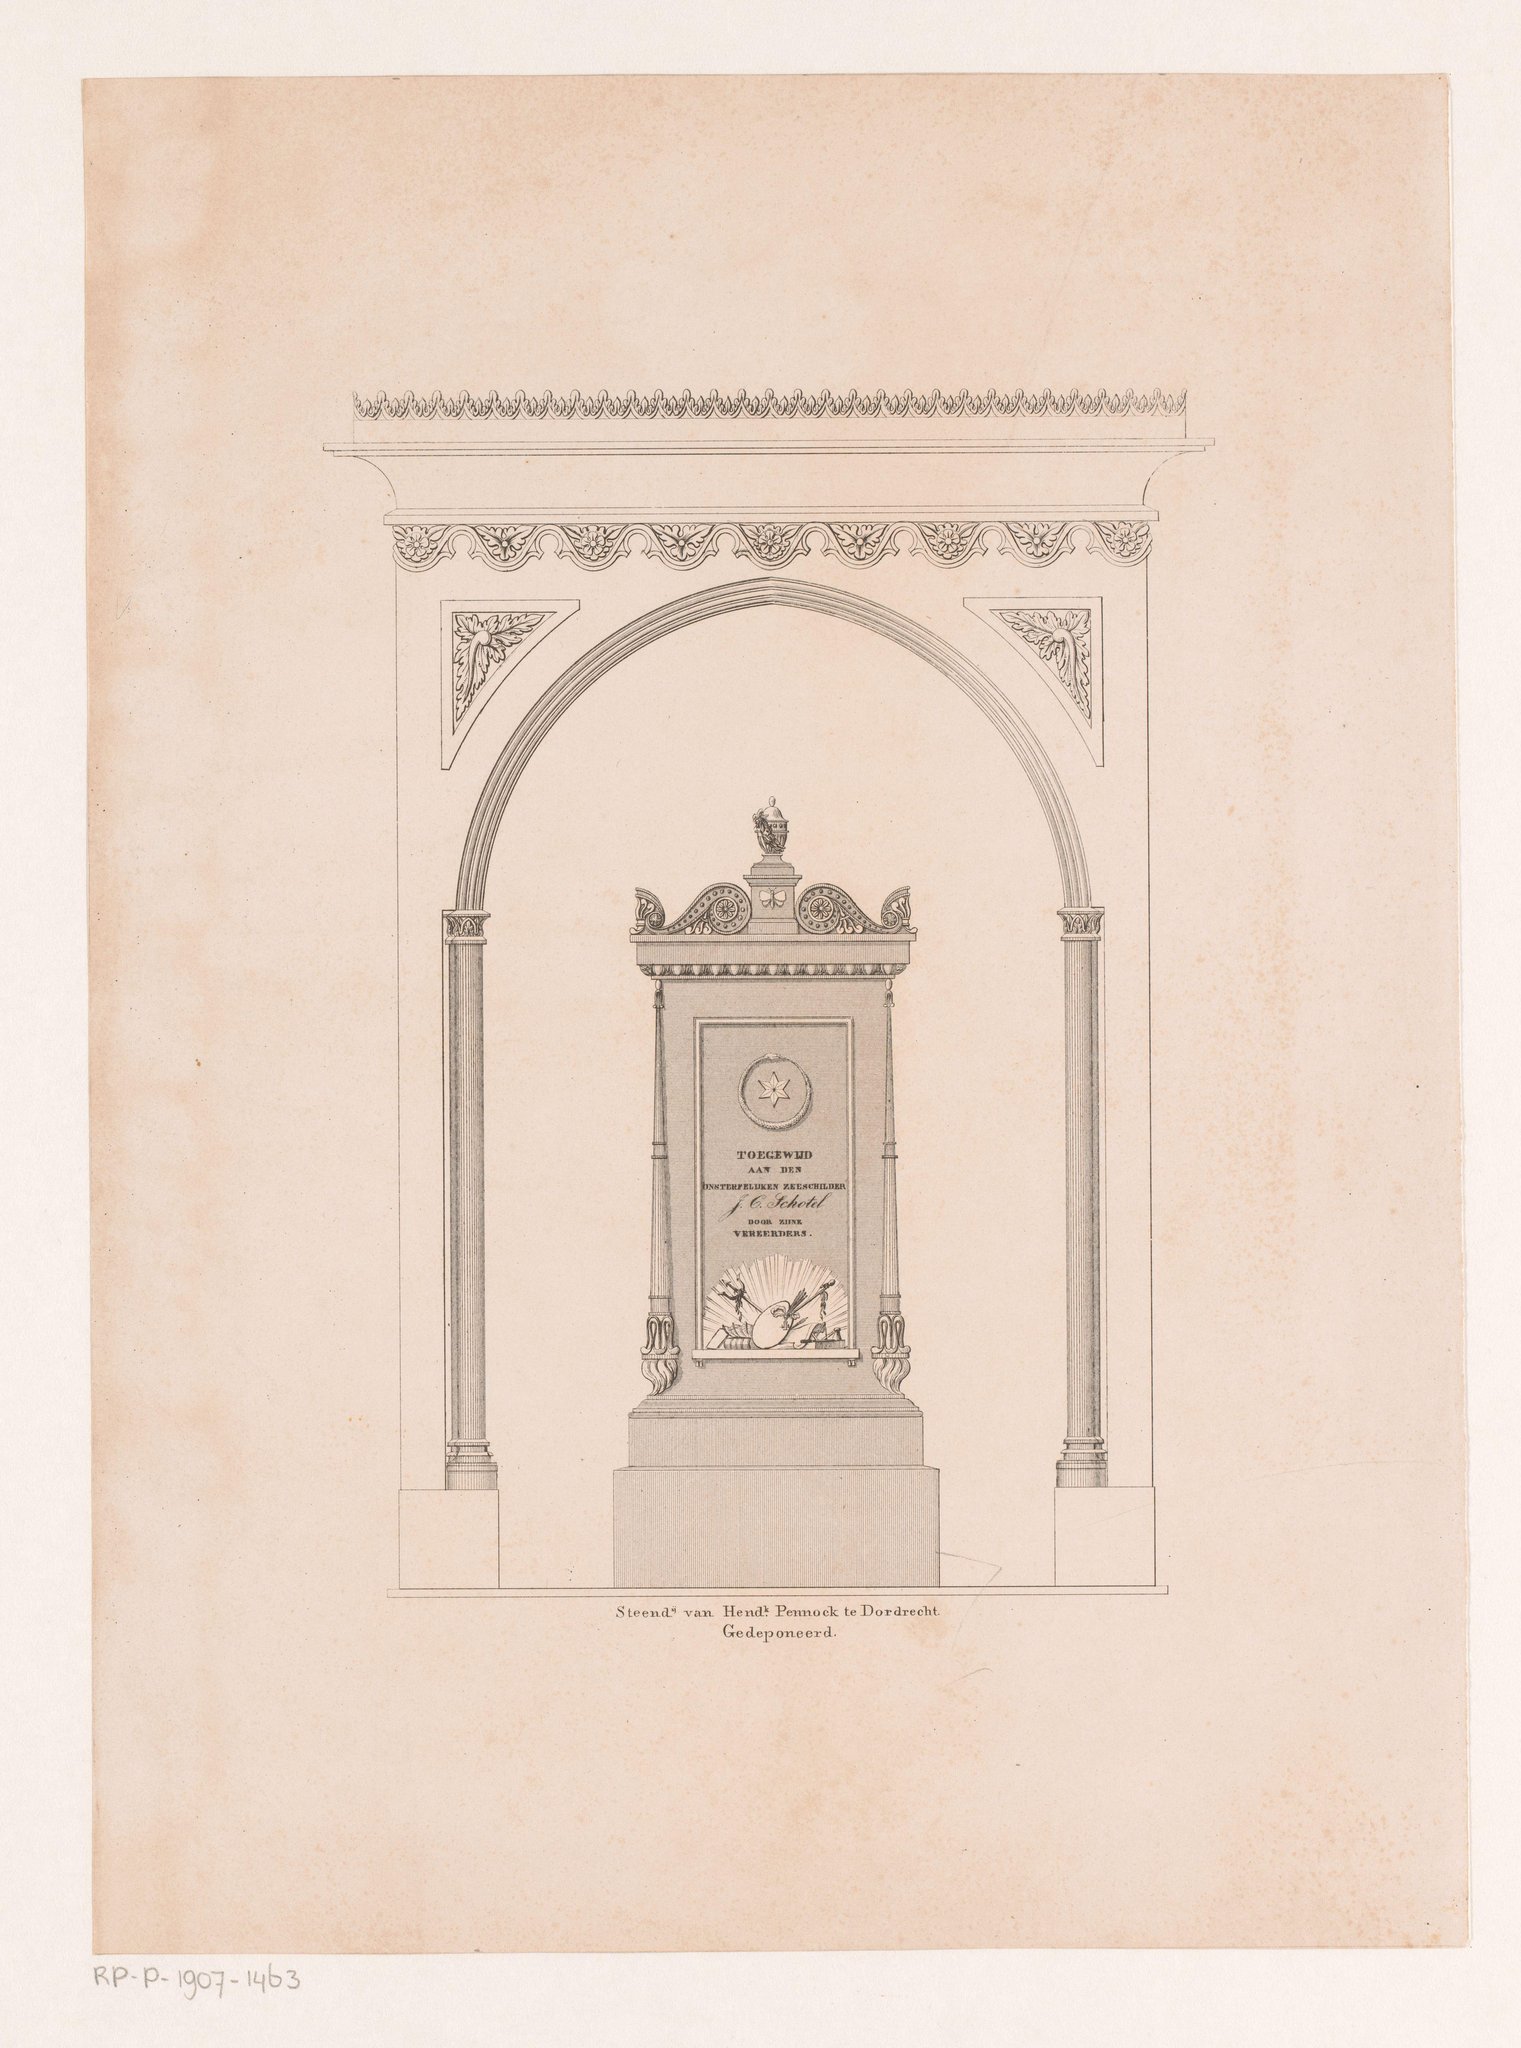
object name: print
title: Toegewijd aan den onsterfelijken zeeschilder J.C. Schotel door zijne vereerders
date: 1838-1848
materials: paper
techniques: lithograph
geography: dordrecht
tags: dordrecht, painter, draughtsman, johannes christiaan schotel, grave, tomb, epitaph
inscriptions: collector's mark: Lugt 2228, : ‘Gedeponeerd.’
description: Bouwkundige afbeelding van het monument in de Grote Kerk in Dordrecht. Het graf staat op een sokkel en is gedecoreerd met een eierlijst, voluten en een grafurn. Erop afgebeeld schildersattributen, nautische instrumenten, lauriertakken en een ridderorde. Het geheel is geplaatst onder een spitsboog en wordt geflankeerd door twee zuilen.